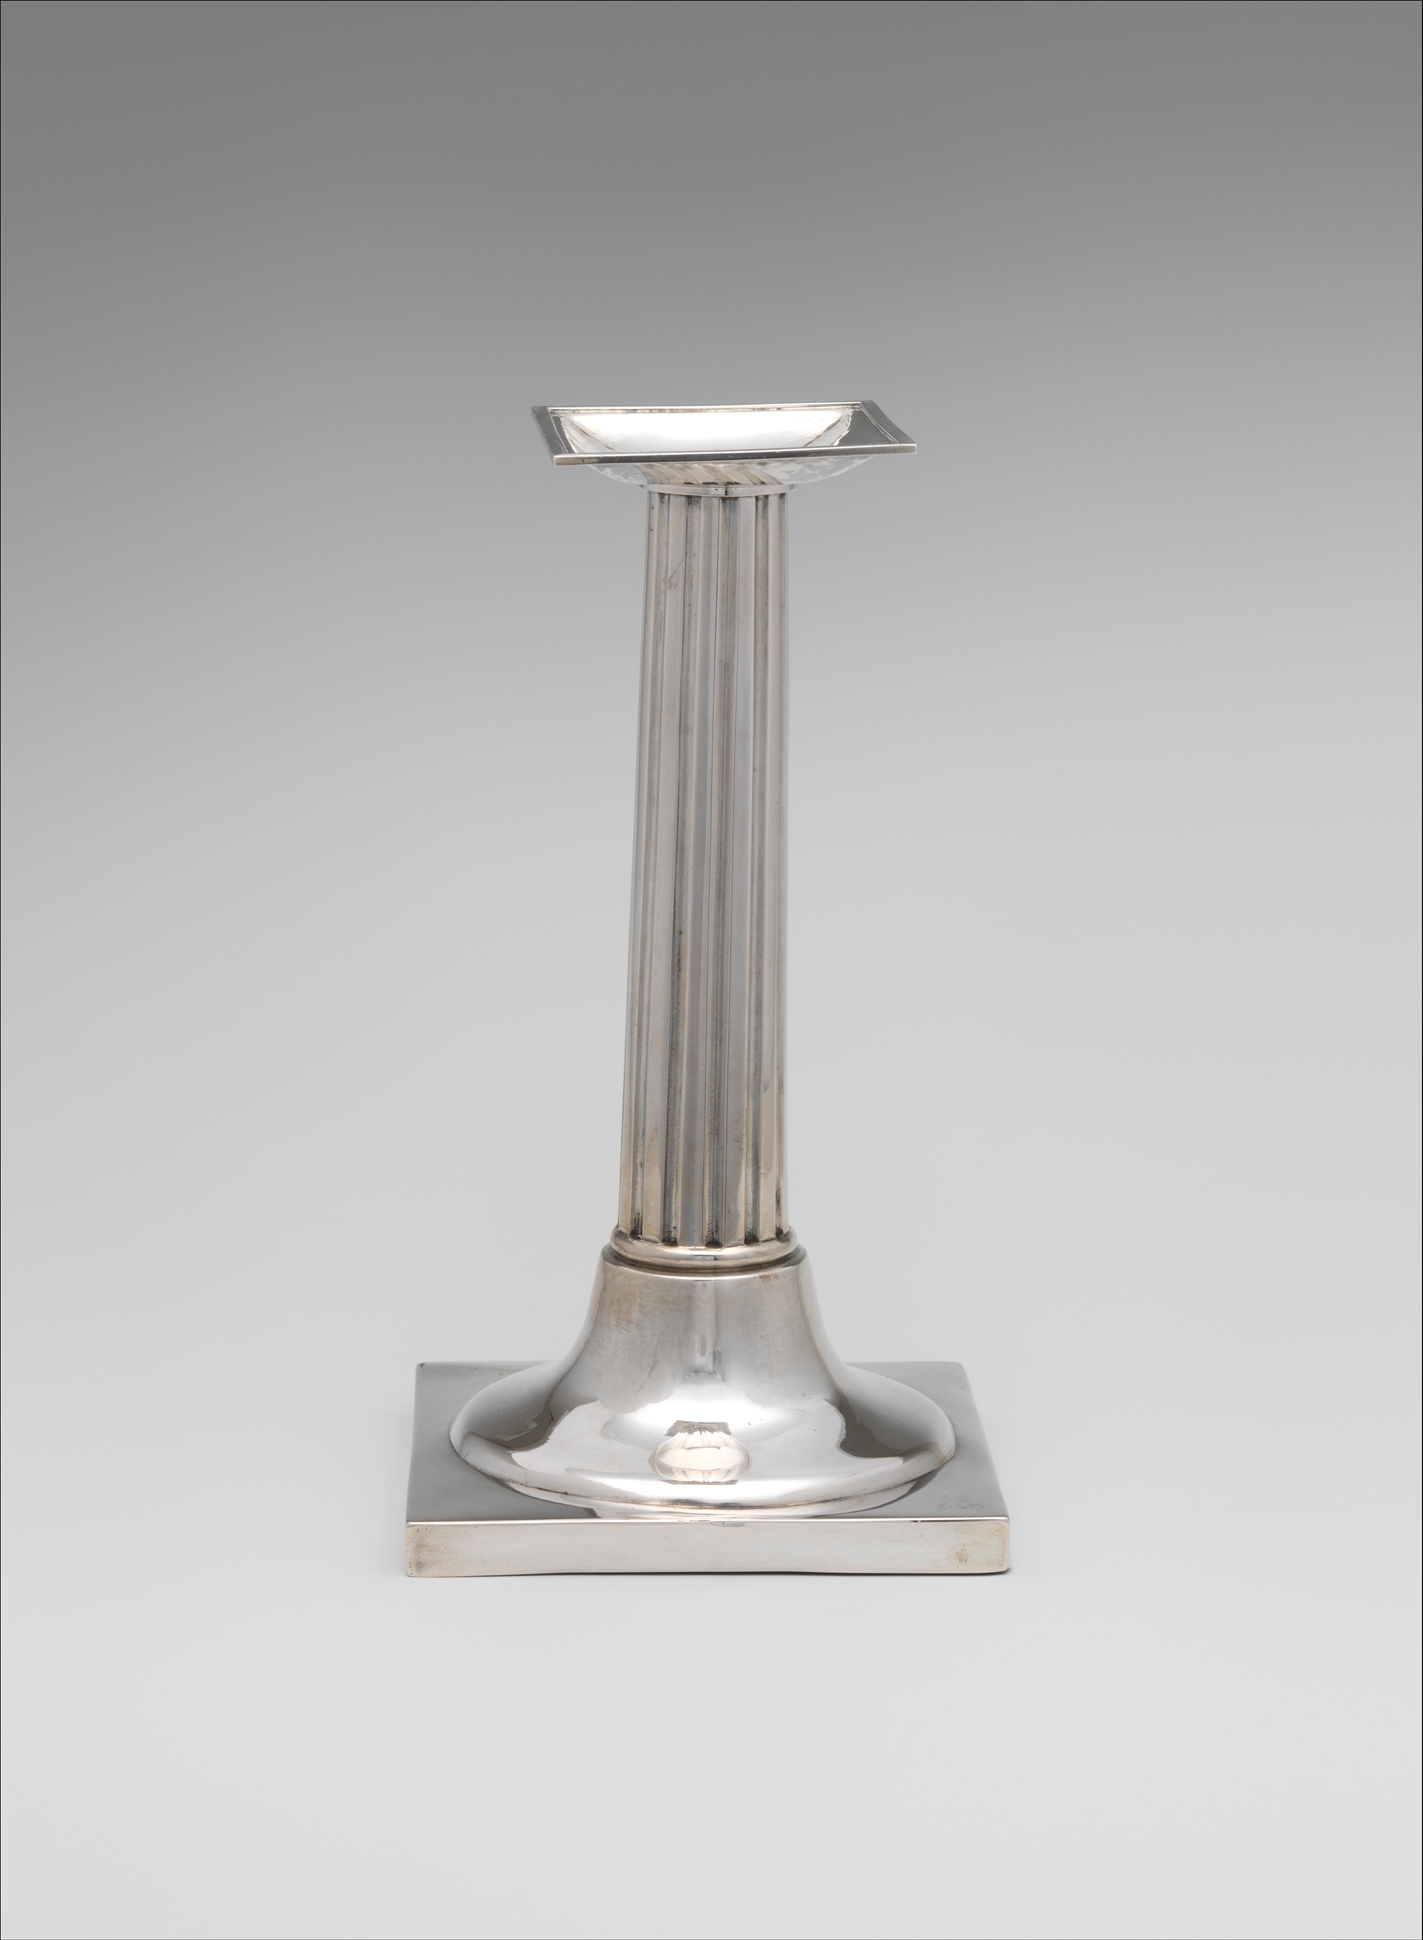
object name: candlestick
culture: american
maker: isaac hutton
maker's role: maker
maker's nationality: american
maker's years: 1766-1855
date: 1800-1815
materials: silver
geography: united states